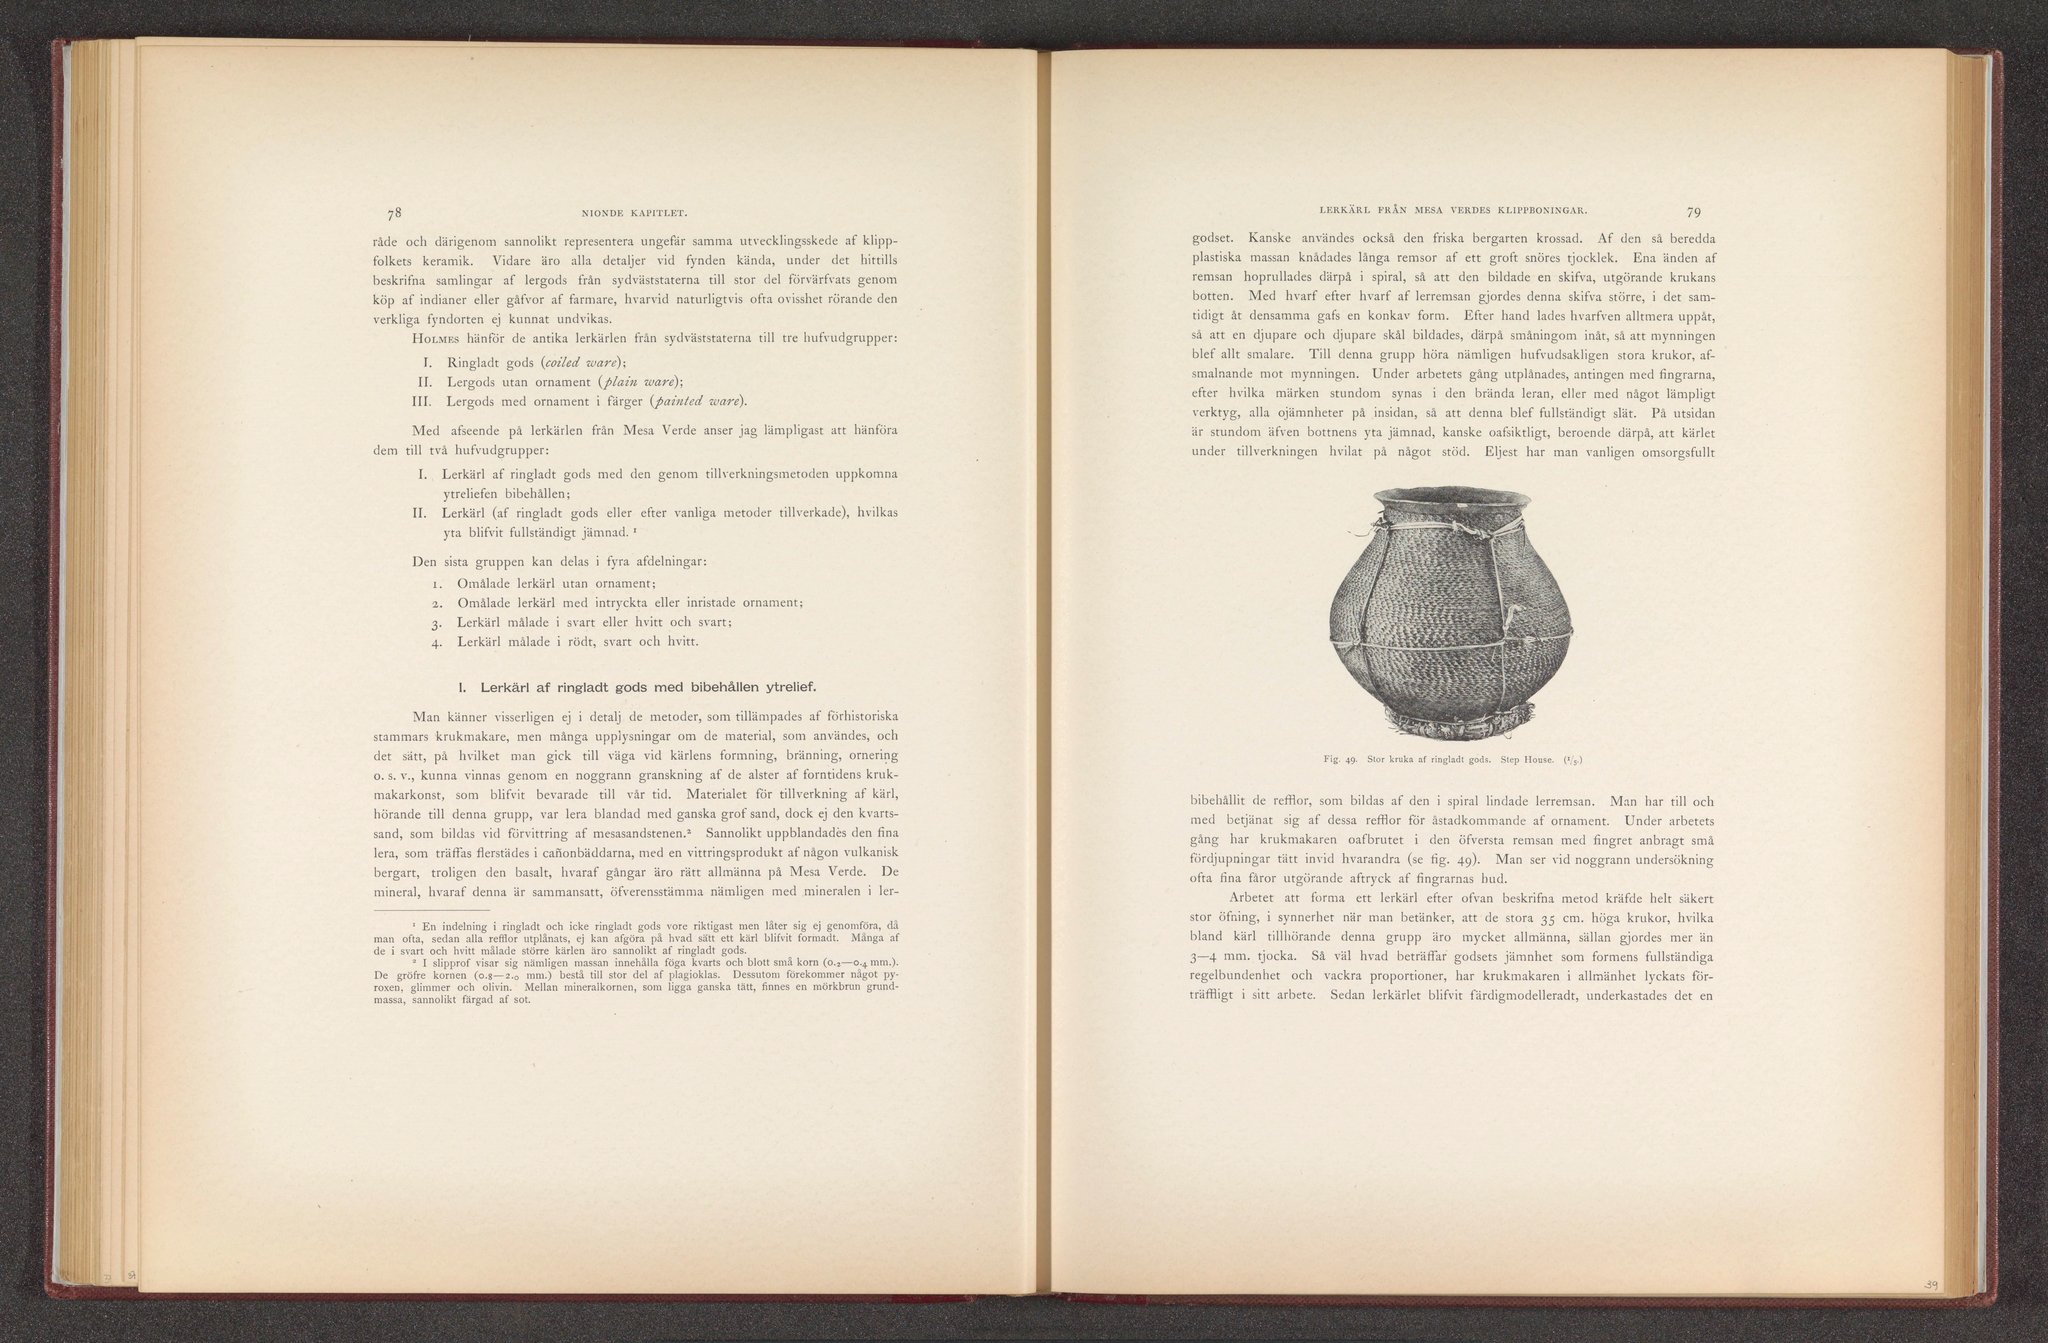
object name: photomechanical print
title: Stor kruka af ringladt gods. Step House (1/5)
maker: gustaf nordenskiöld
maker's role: fotograaf, schrijver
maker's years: 1868-1895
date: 1891-1893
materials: paper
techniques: autotype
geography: mesa verde national park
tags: kitchen-utensils: pot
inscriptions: number: ‘Fig. 49.’